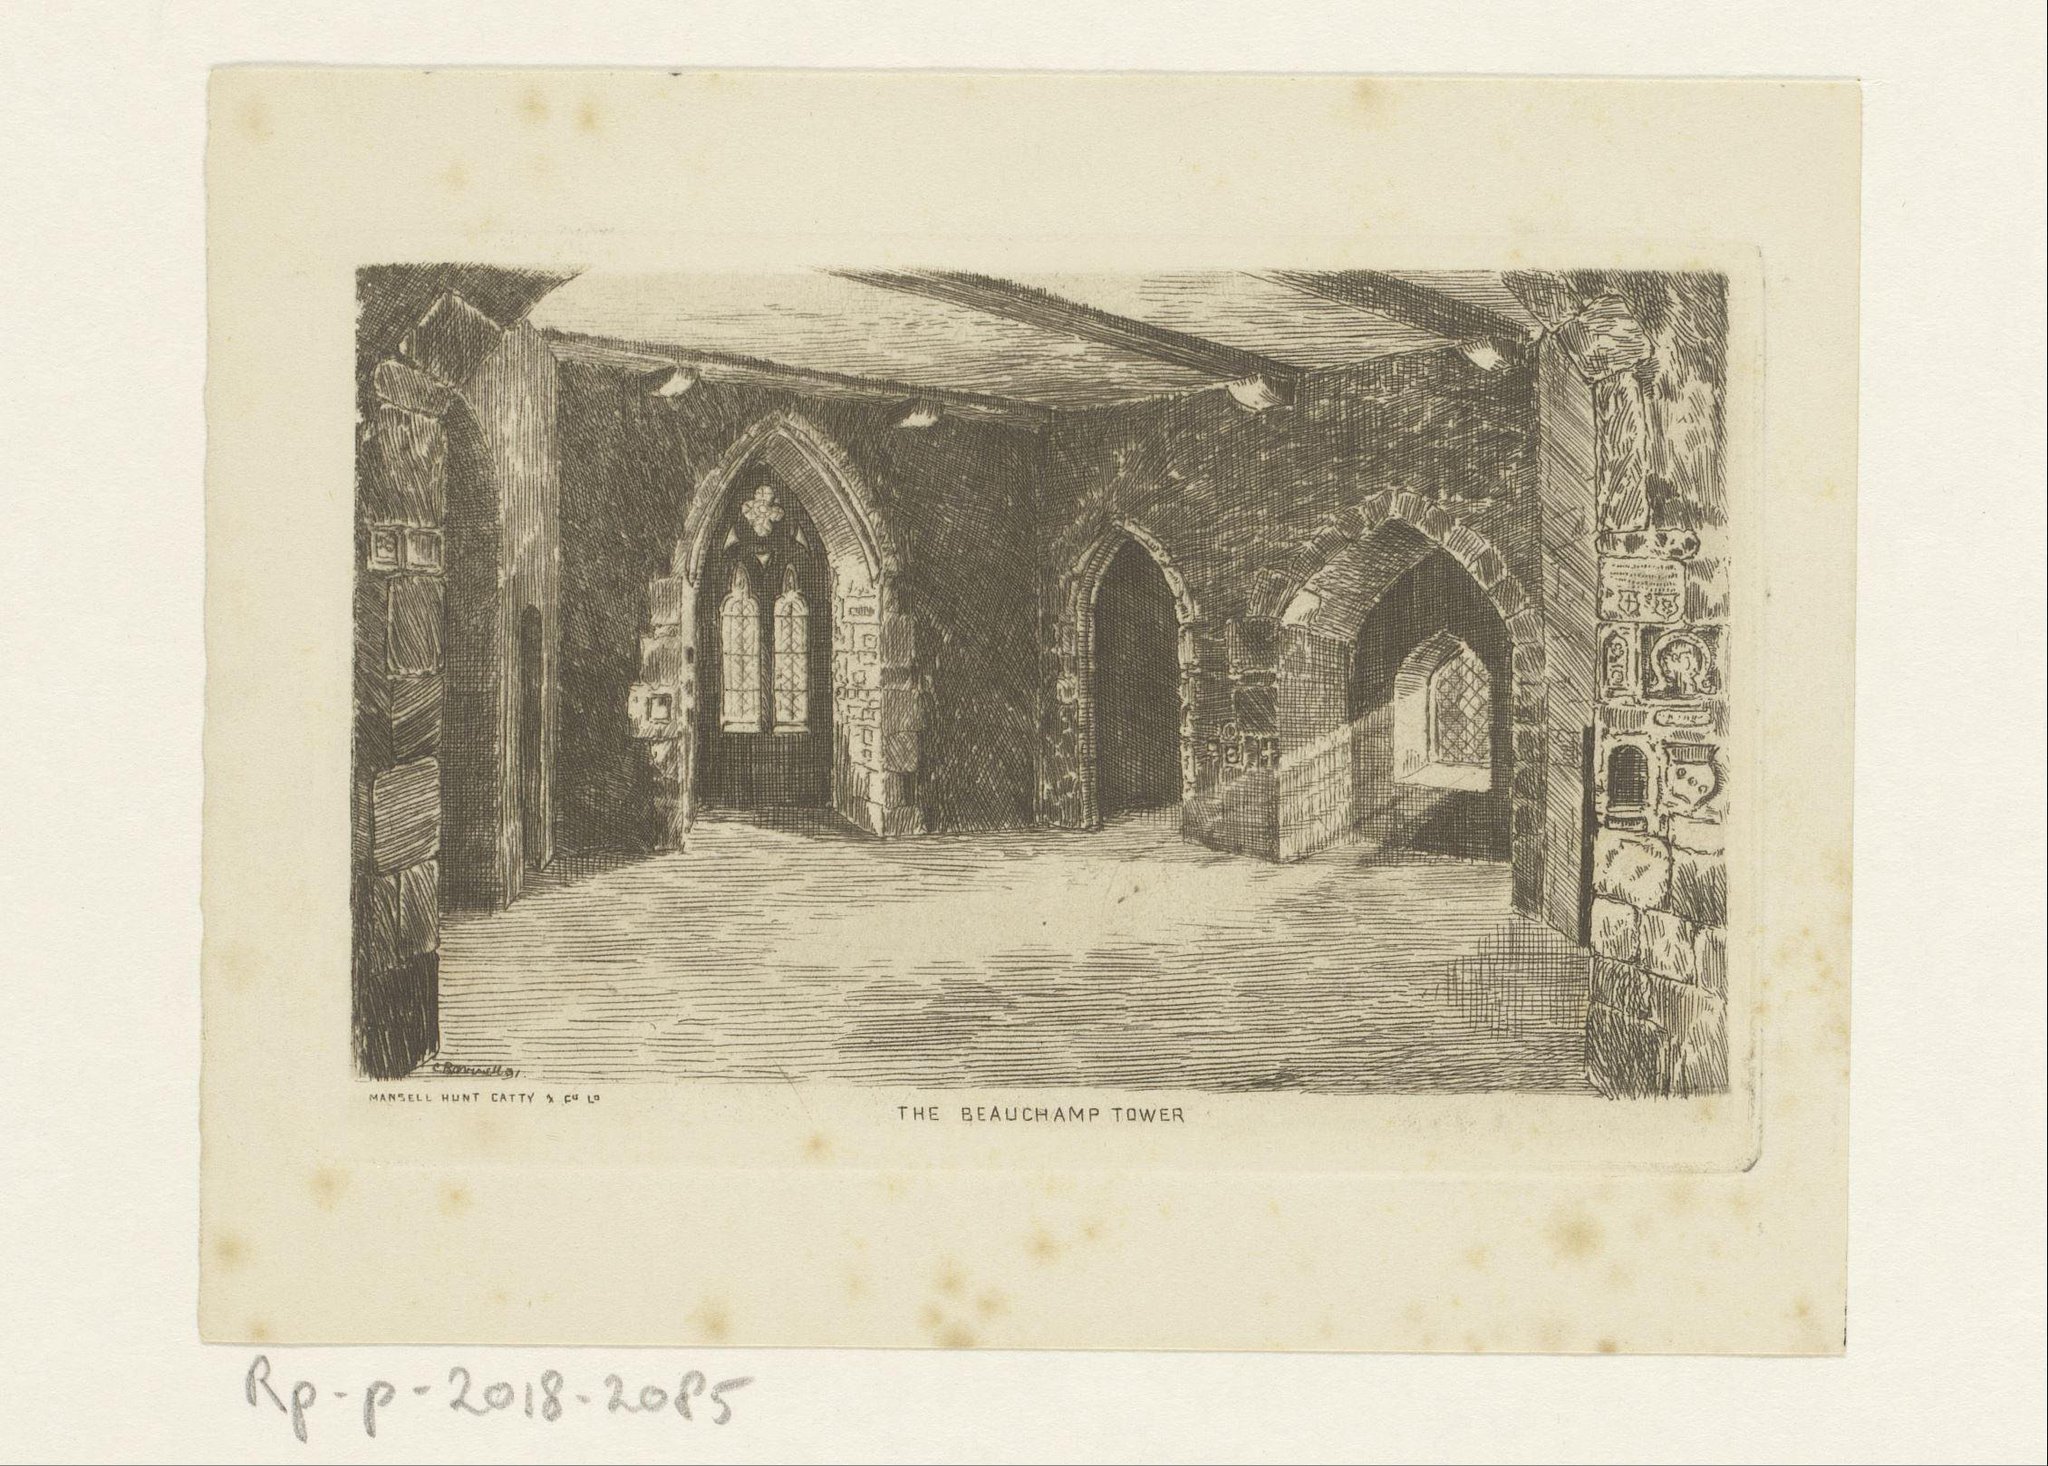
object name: print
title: Gezicht op de binnenkant van de Beauchamp Tower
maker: Anonymous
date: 1850-1949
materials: paper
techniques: etching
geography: london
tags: fortress, tower (of house or building)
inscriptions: collector's mark: Lugt 2228